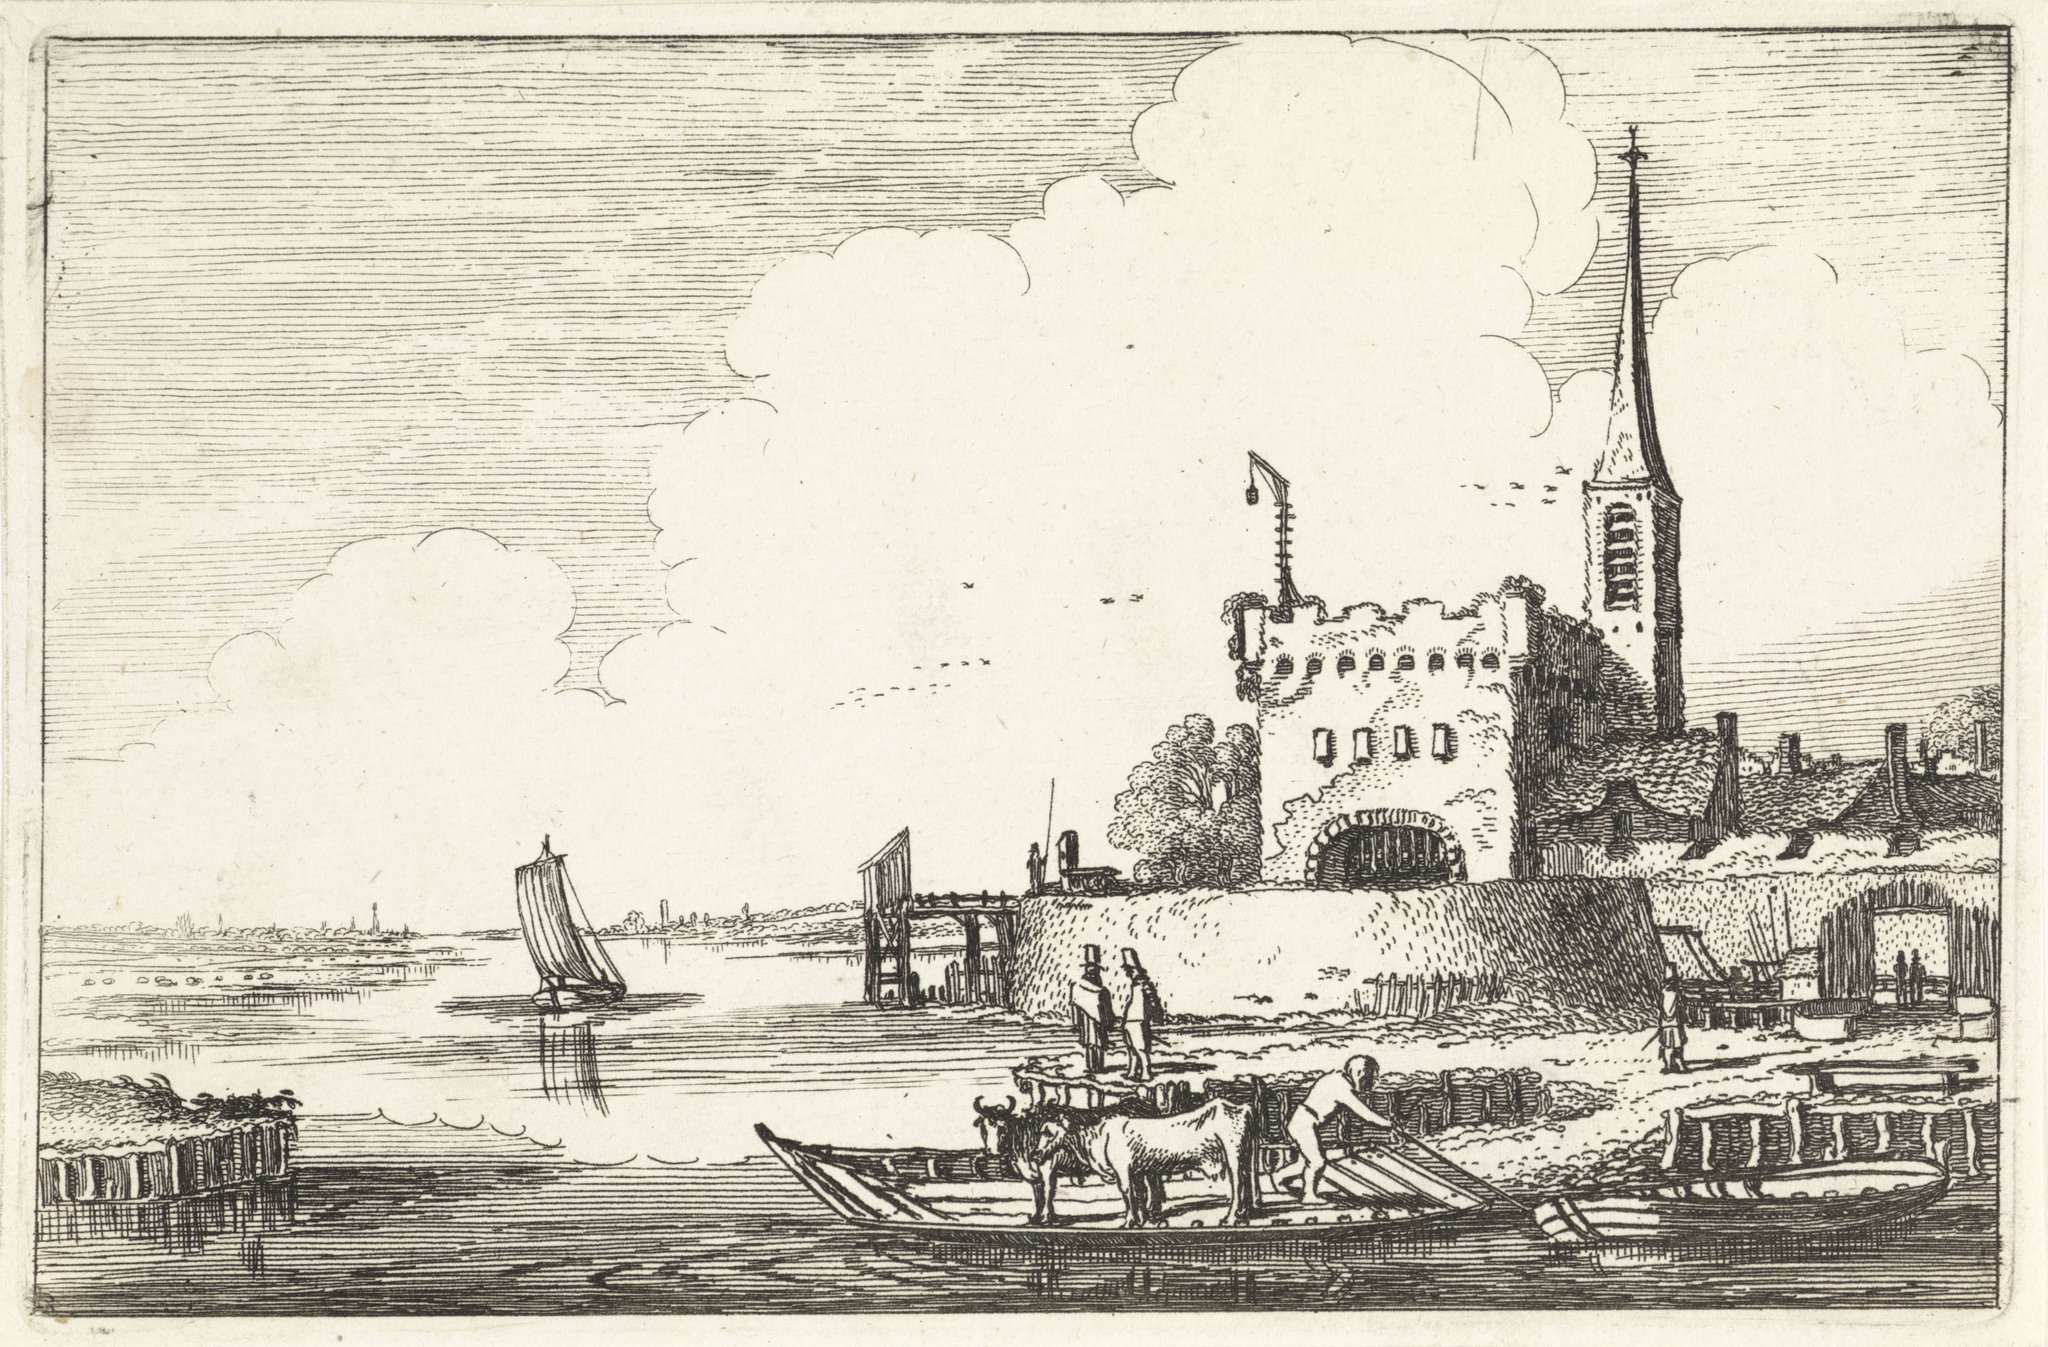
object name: print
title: Pont met vee bij een fort in een rivierlandschap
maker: jan van de velde (ii)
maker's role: draughtsman, painter, print maker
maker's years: 1593-1641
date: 1616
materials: paper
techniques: etching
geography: northern netherlands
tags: fortress, cow, river, ferry, bastion, bulwark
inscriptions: collector's mark: Lugt 964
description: Een pont met daarop een figuur en twee koeien bij een fort in een weids rivierlandschap. Oorspronkelijk prent van een serie van in totaal zestig prenten met landschappen, verdeeld over vijf delen van elk twaalf prenten.